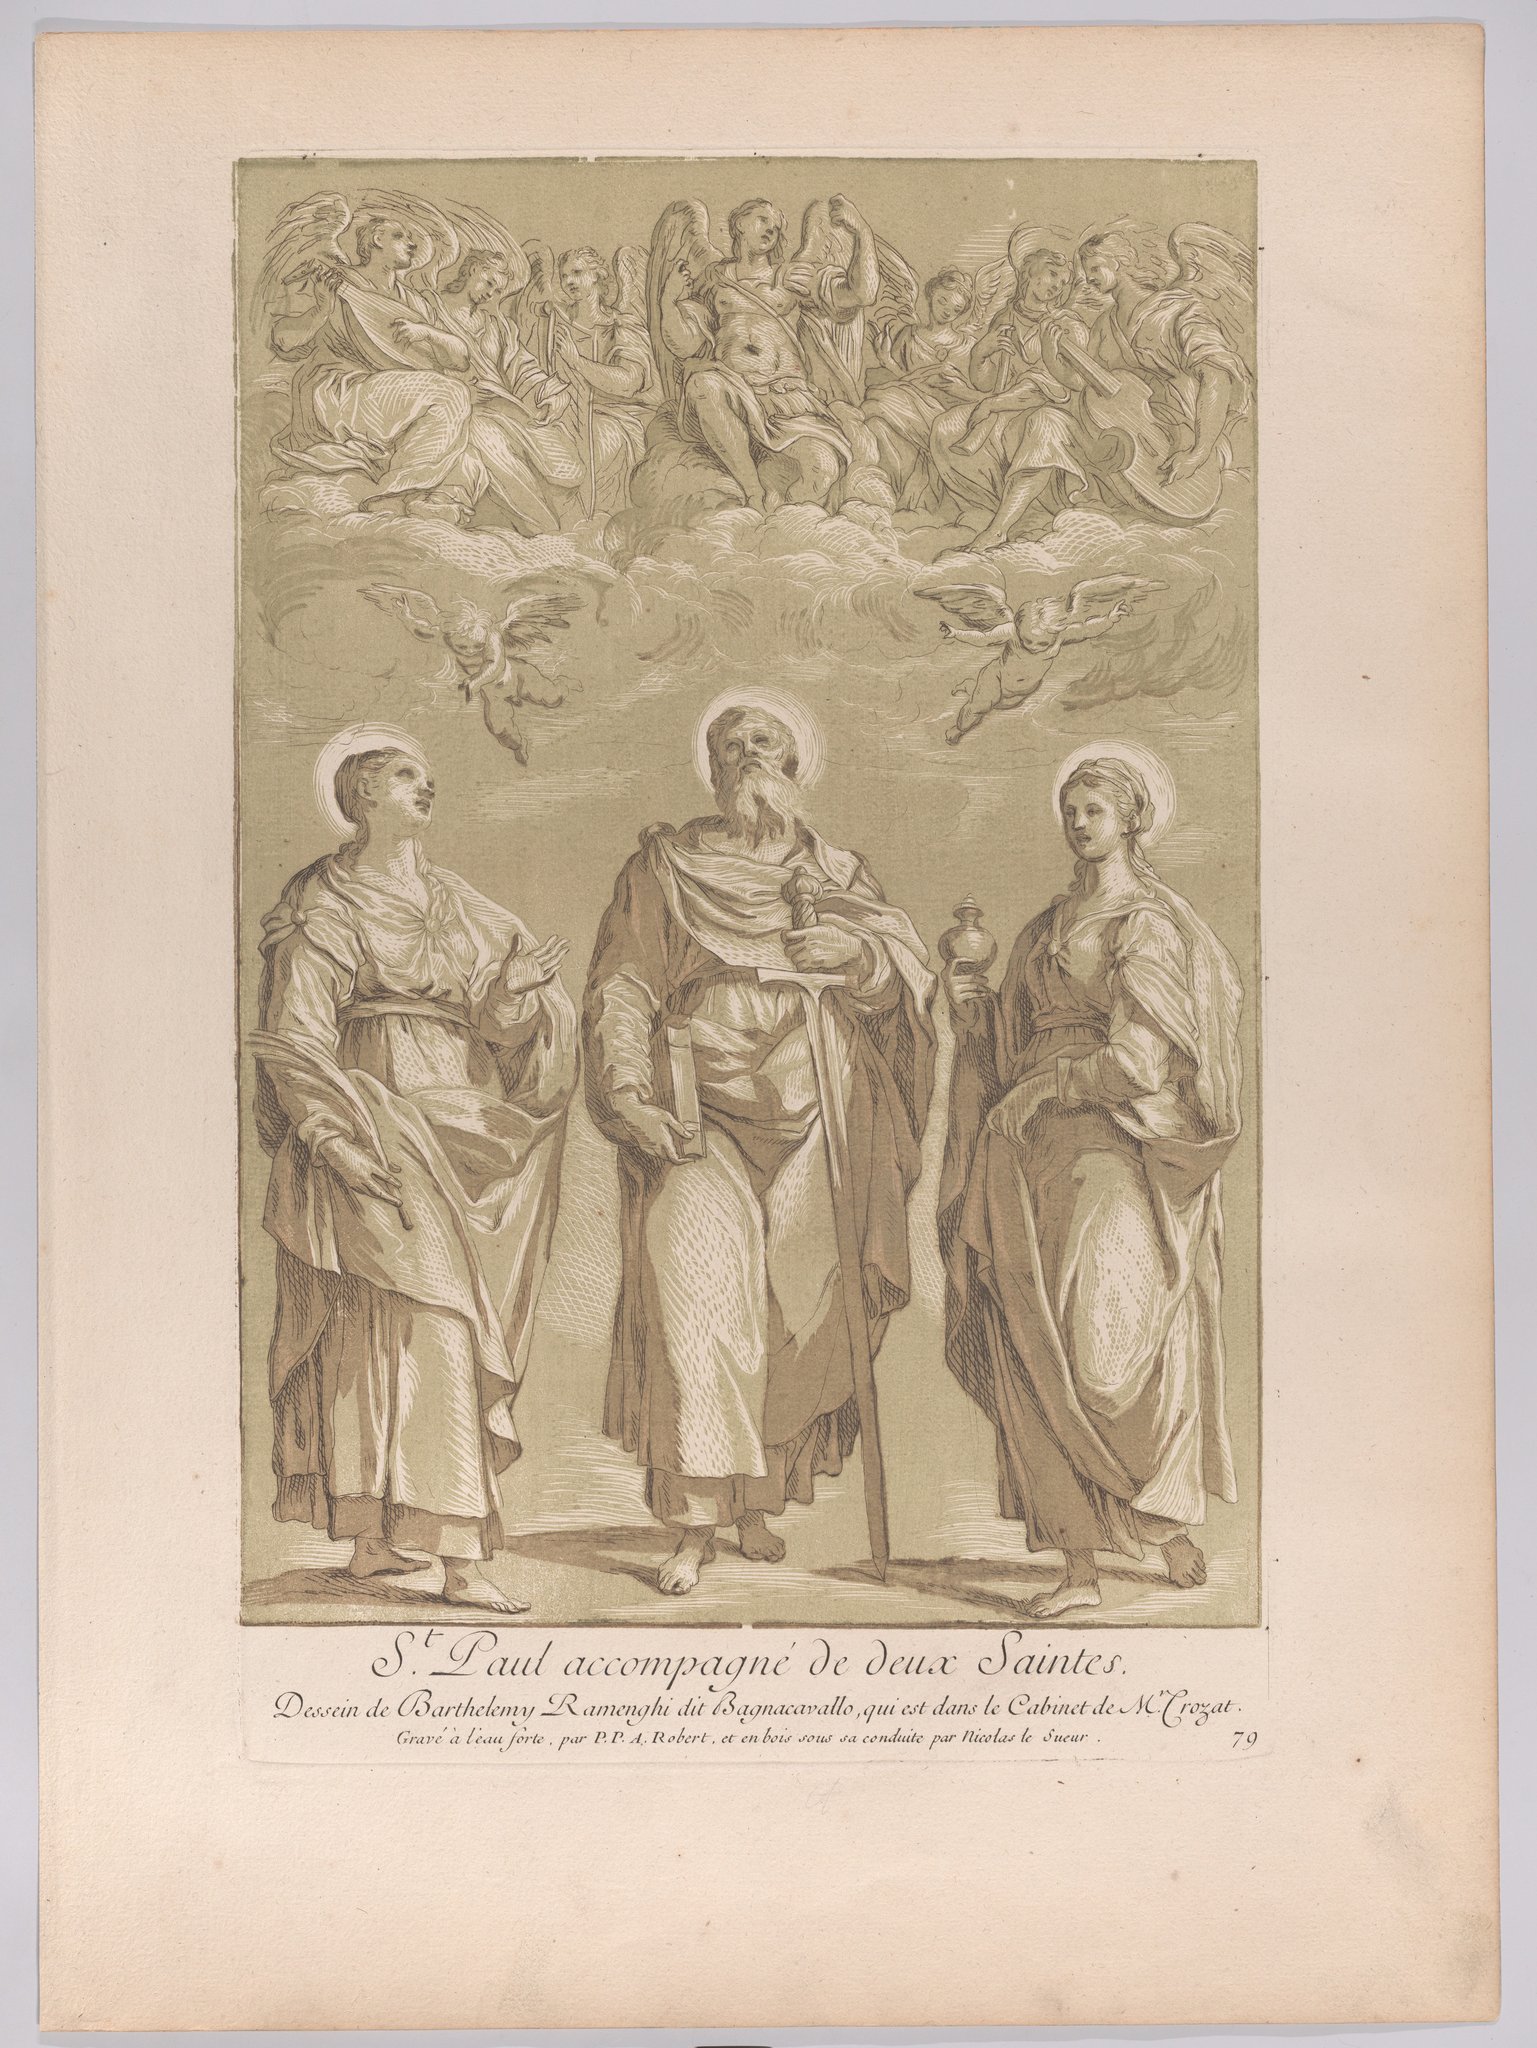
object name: print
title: Saint Paul accompanied by two female saints with angels above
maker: paul ponce antoine robert-de-seri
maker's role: artist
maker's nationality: french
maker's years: 1686-1733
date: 1729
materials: ink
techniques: aquatint, etching